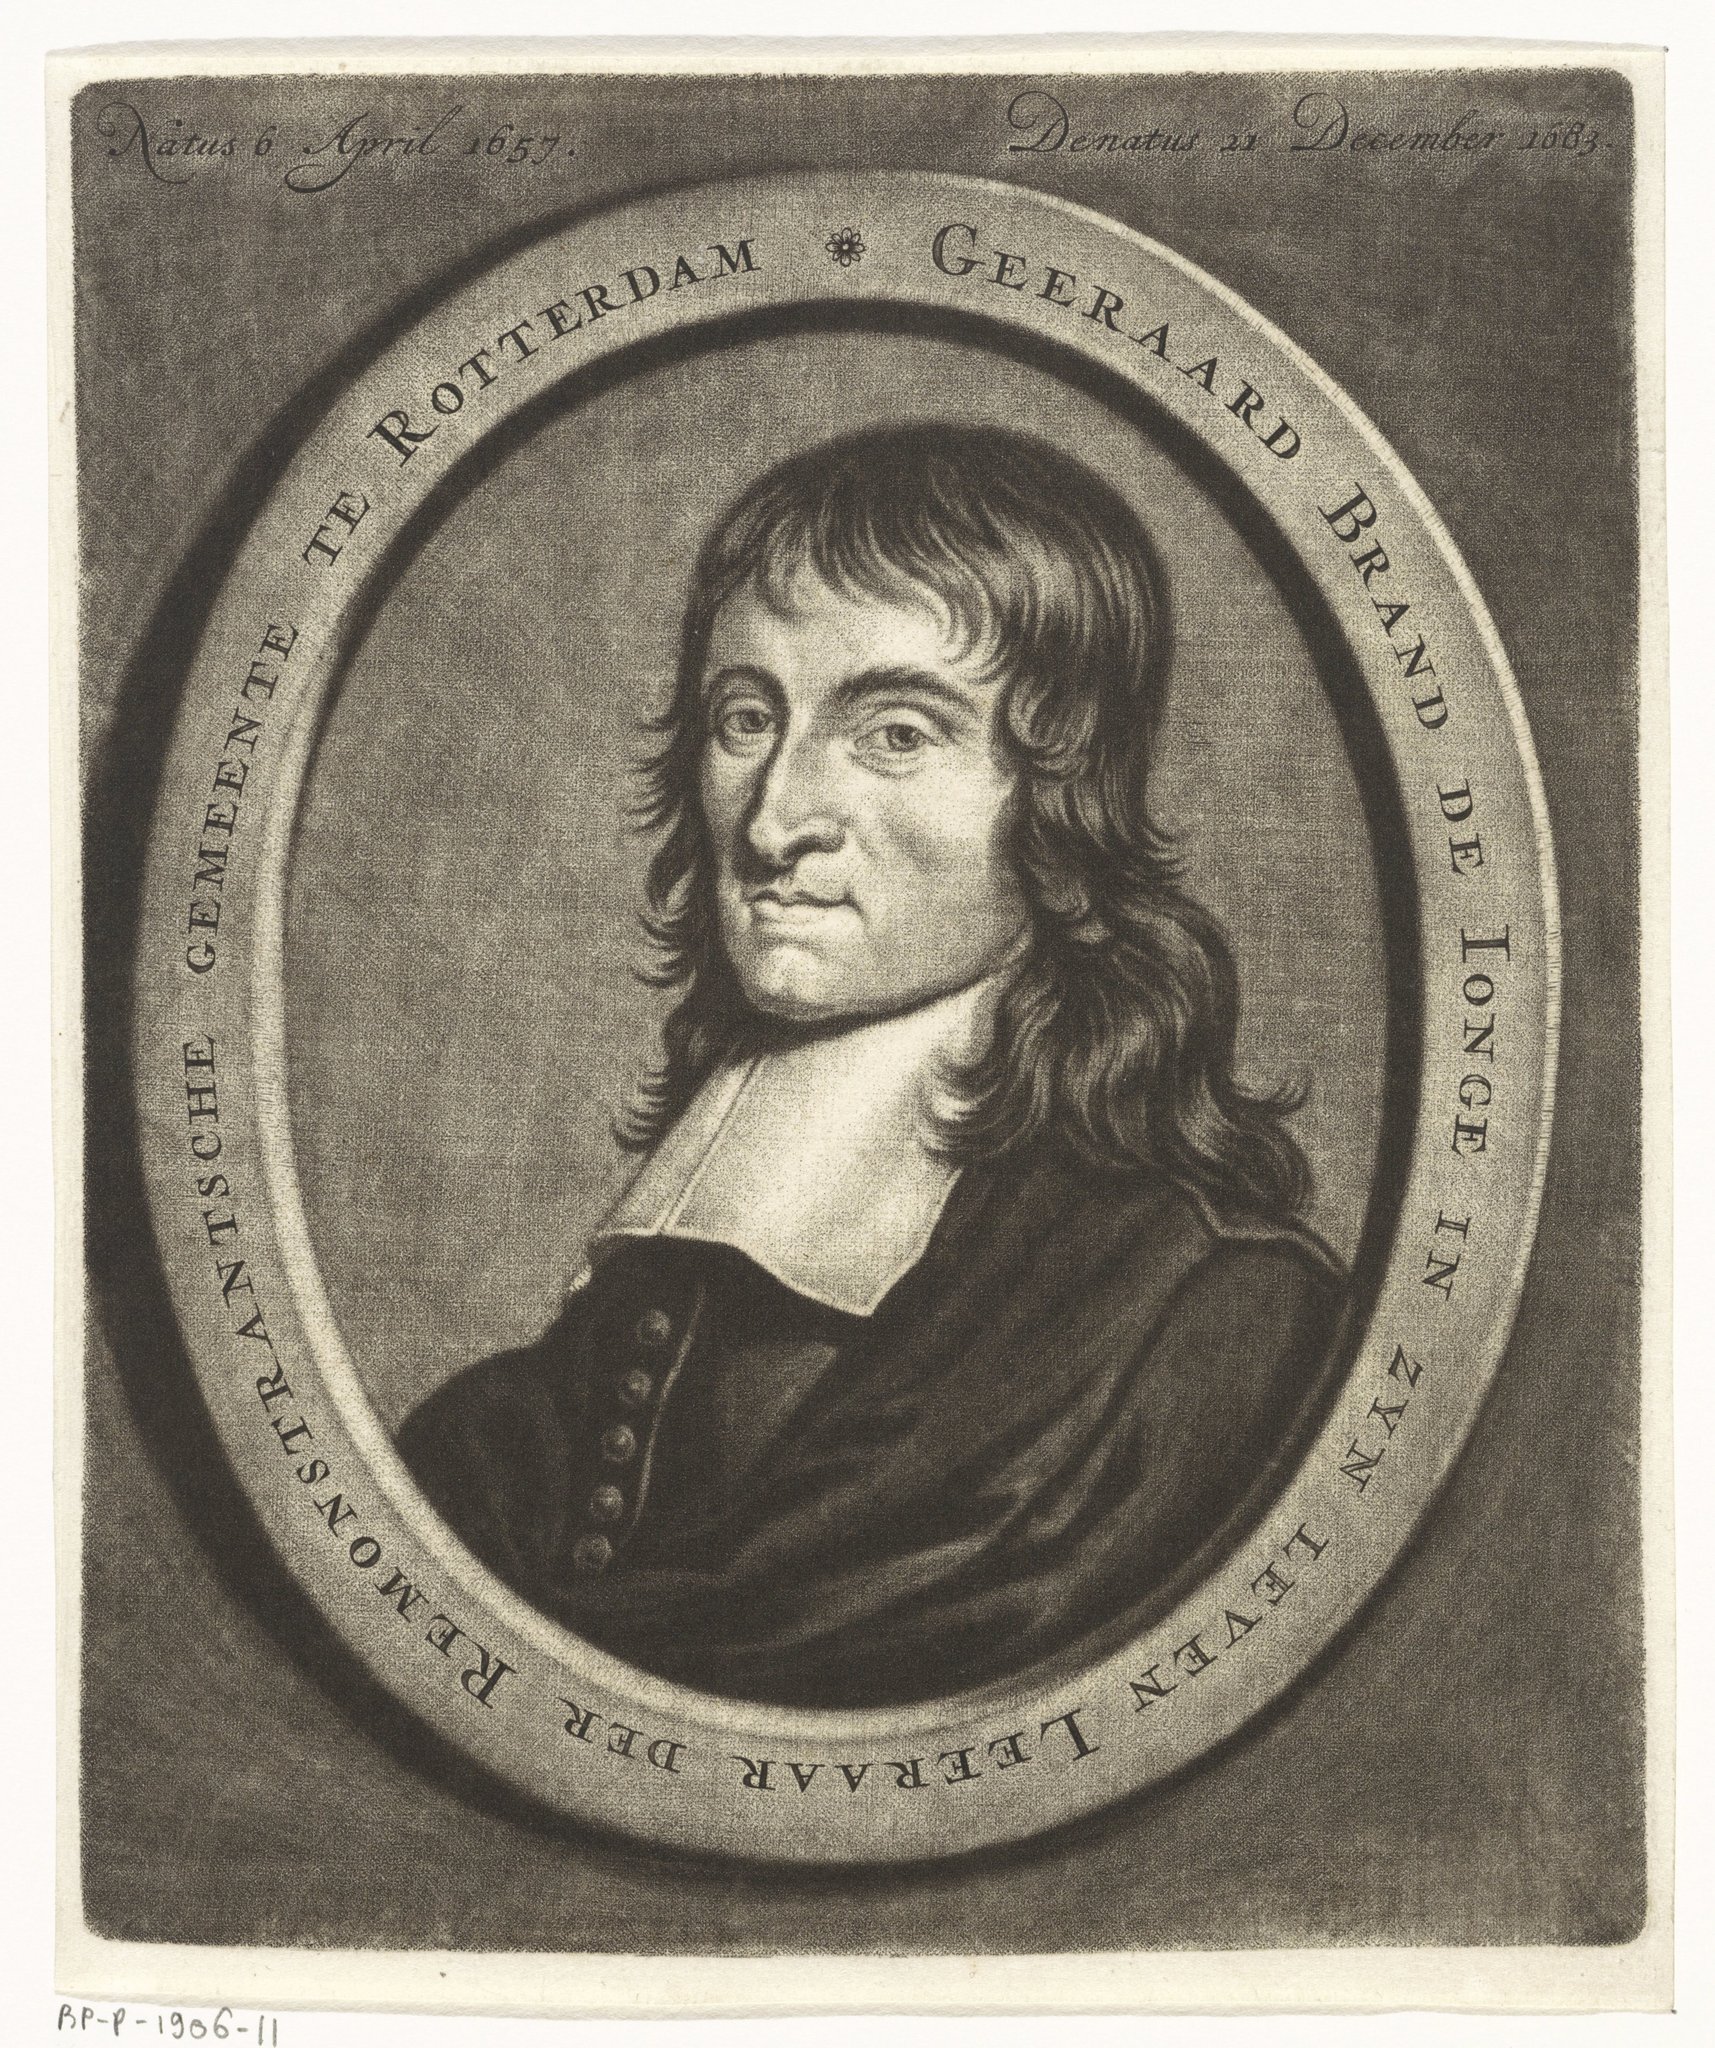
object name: print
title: Portret van de remonstrantse predikant Gerard Brand de Jonge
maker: christoffel lubienitzki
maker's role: draughtsman, painter, print maker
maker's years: 1659-1729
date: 1683-1724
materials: paper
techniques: engraving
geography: amsterdam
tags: rotterdam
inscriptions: collector's mark: Lugt 2228